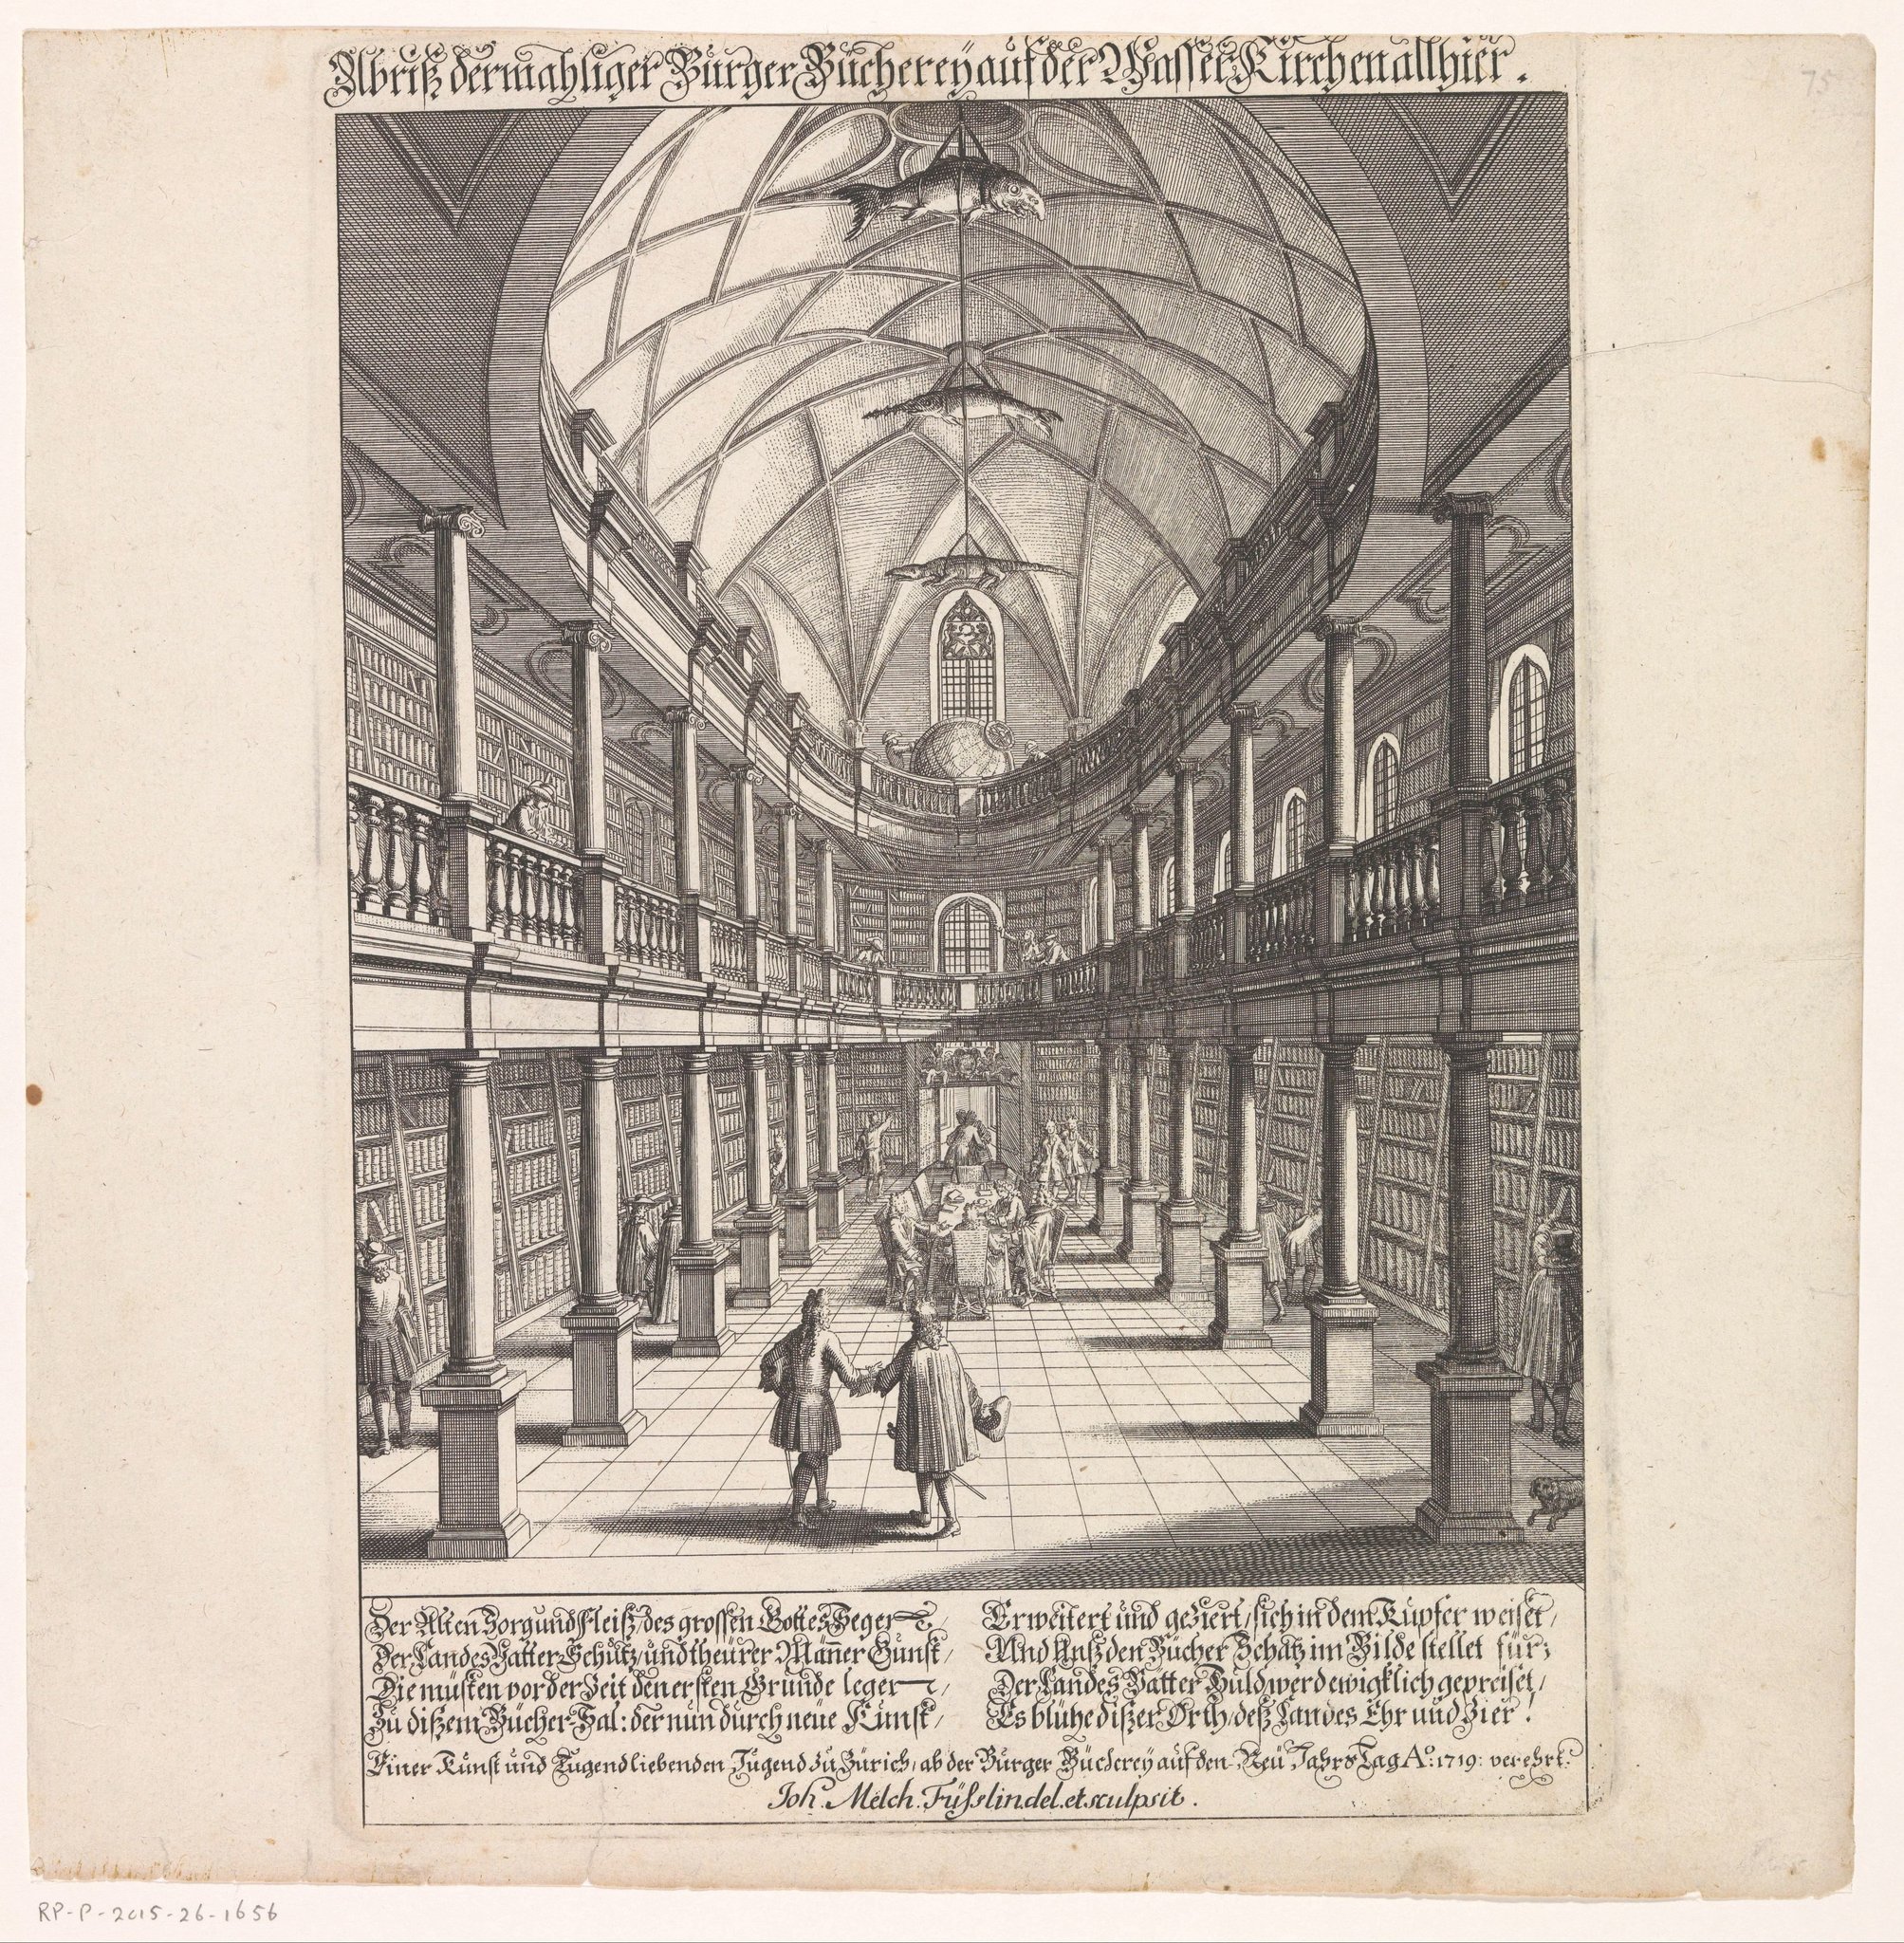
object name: print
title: Abritz dermahliger Burger Büchereij auf der Wasser Kirchen allhier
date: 1719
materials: paper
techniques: etching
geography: zurich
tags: writing-table, writing-desk, public library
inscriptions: collector's mark: Lugt 4779, collector's mark: Lugt 2228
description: Interieur van de Wasserkirche te Zürich, in gebruik als bibliotheek. In het midden van de zaal staat een leestafel. Aan het plafond hangen een opgezette krokodil en twee vissen. Op de bovenste verdieping is een globe te zien. Onder een achtregelig vers in het Duits.